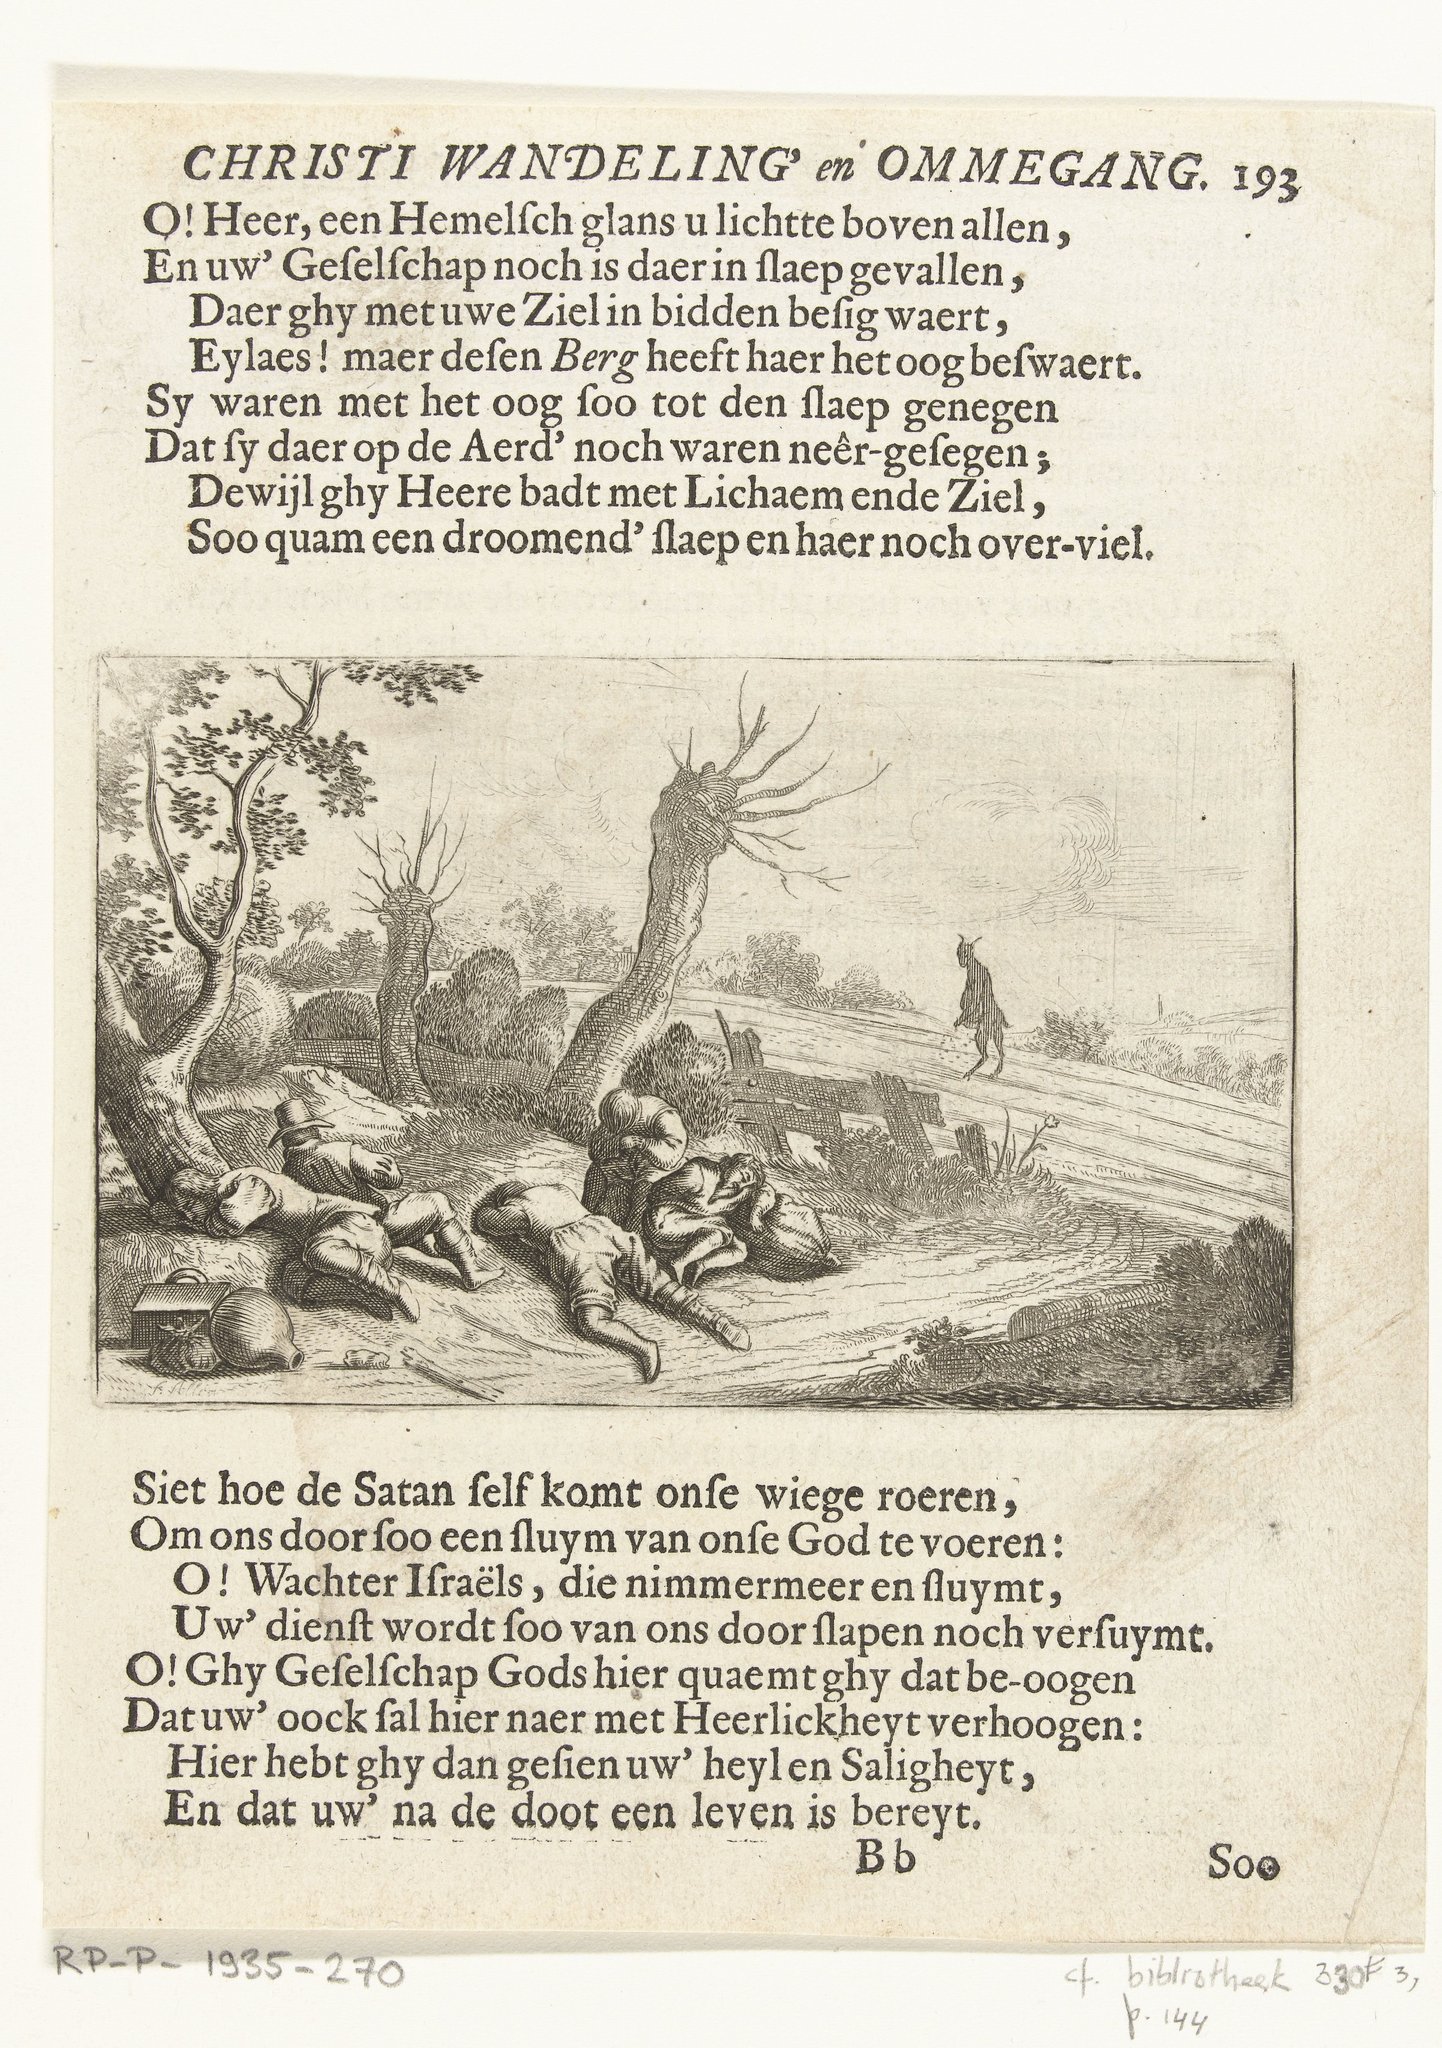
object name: book illustration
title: Satan onkruid zaaiende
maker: frans allen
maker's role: draughtsman, print maker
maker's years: -1685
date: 1660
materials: paper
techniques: engraving, etching, letterpress printing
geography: netherlands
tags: while the sower and his servants slept, his enemy (the devil) sowed tares among the wheat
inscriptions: collector's mark: Lugt 2228, collector's mark: Lugt 2760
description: Waarschijnlijk illustratie uit: C. Udemans, Af-beeldinge van de verkeerde werelt: ontdeckende de oude aen-geborene verkeertheyt der menschen, Middelburgh, Pieter Goetthem, Henrick Smidt, 1660. eerder gebruikt in: D.R. Camphuysen, Stichtelycke rymen, om te lesen ofte singhen, Amsterdam, Iacob Colom, 1647. (in RMA bibliotheek 330 F 3, p. 144)